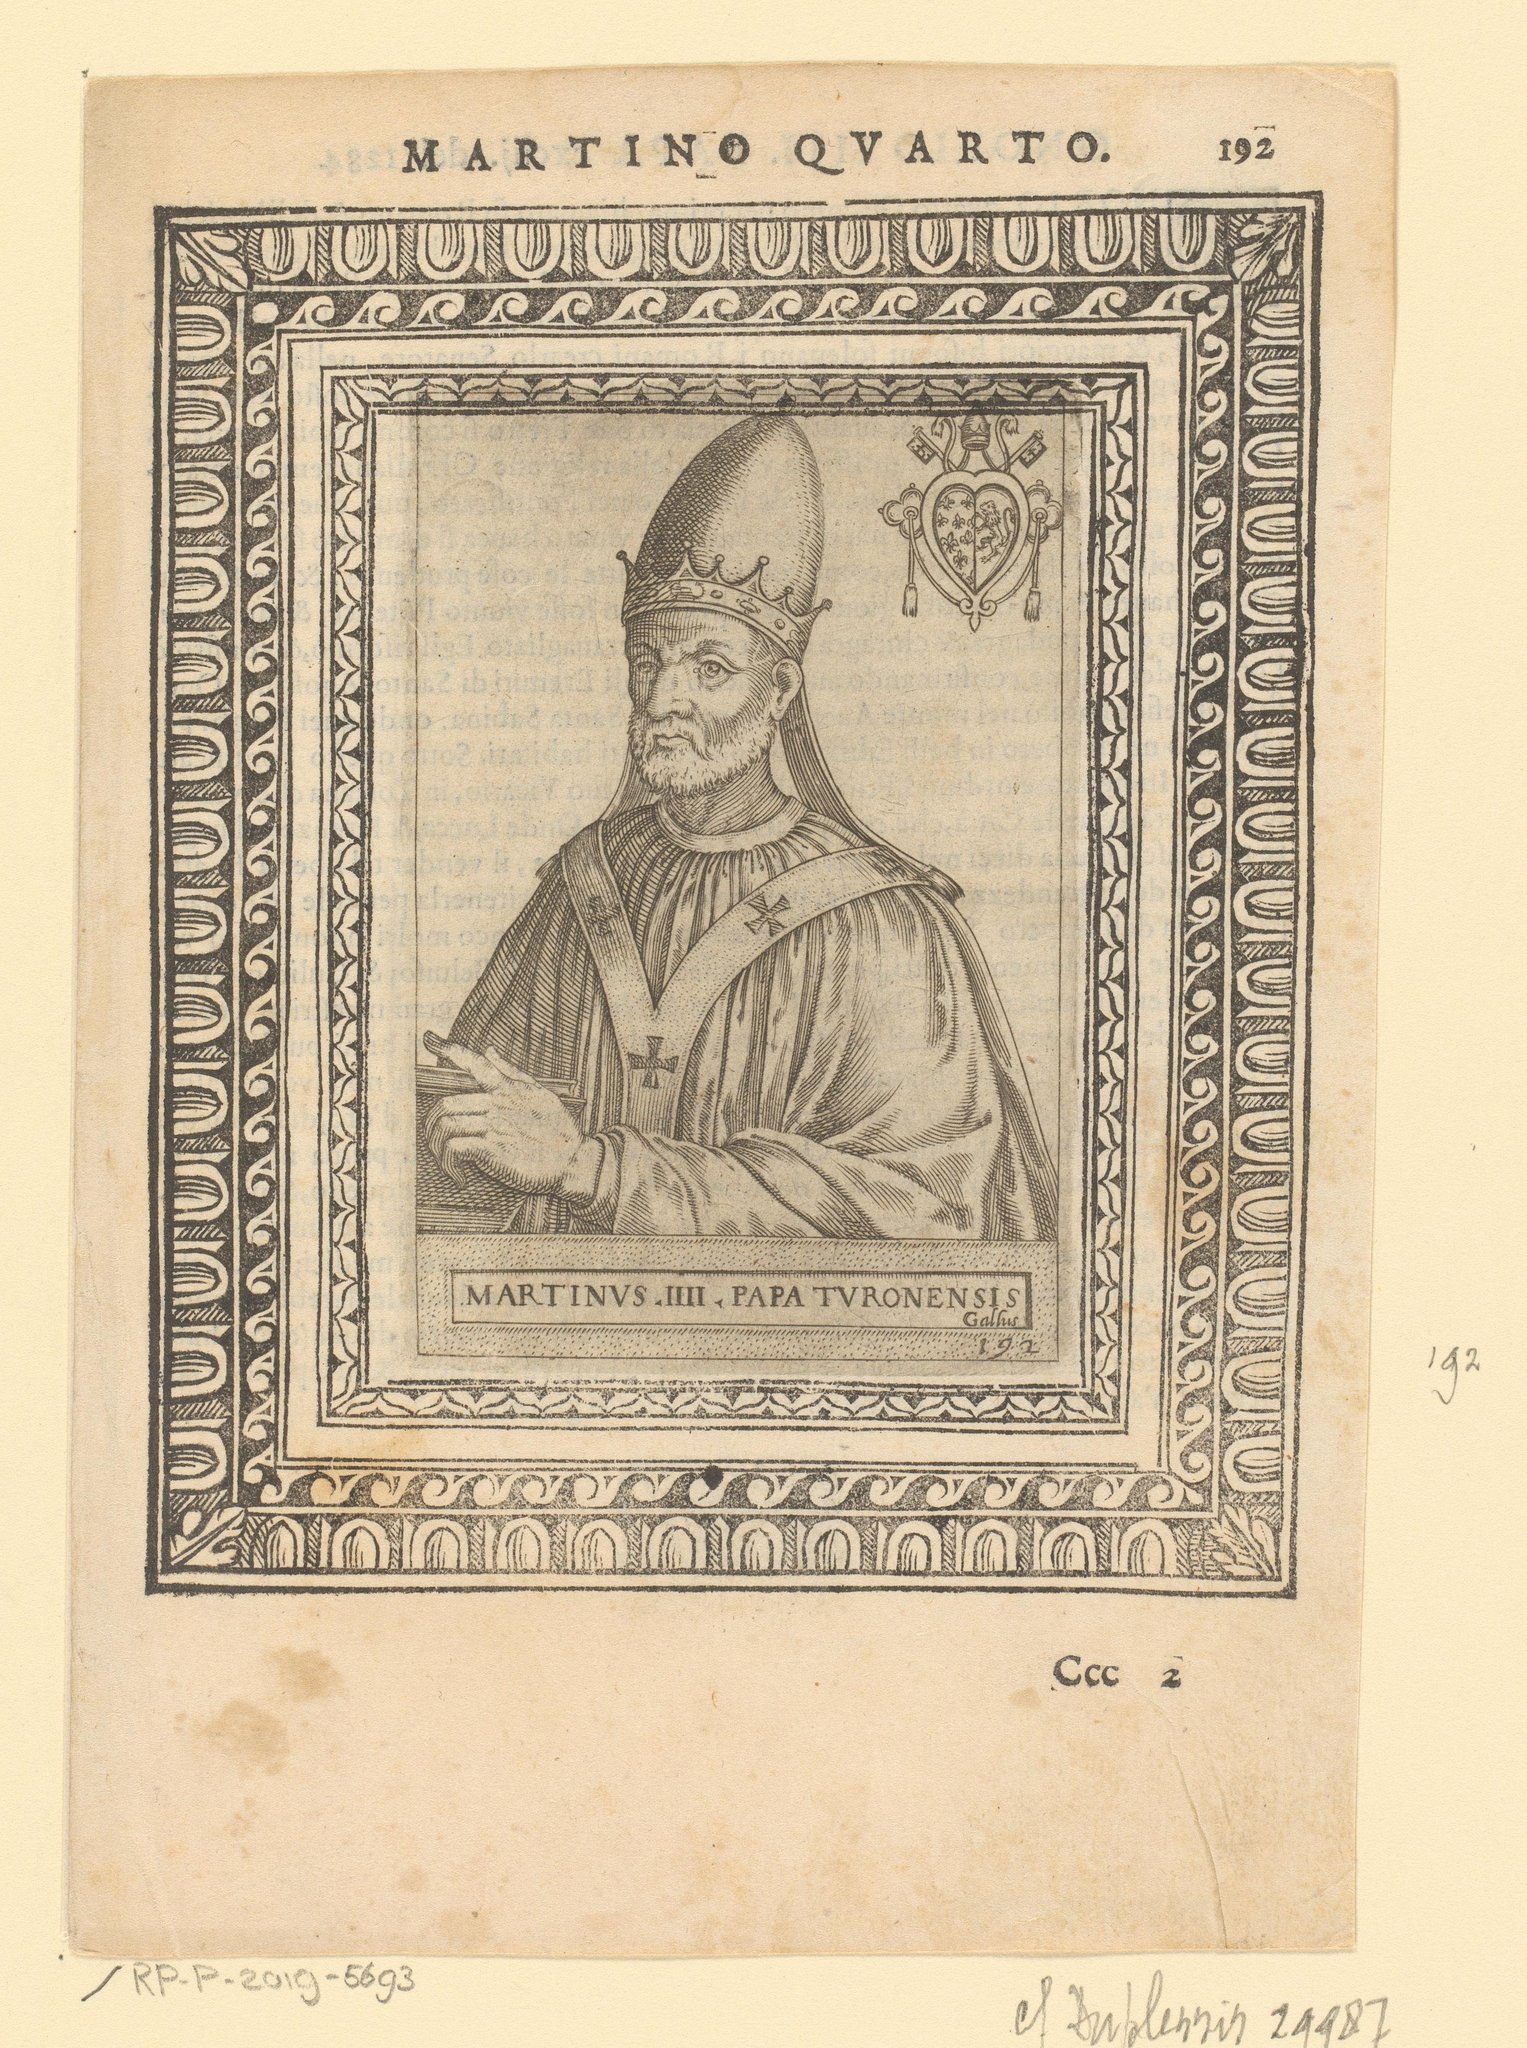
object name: print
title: Martinus IIII Papa Turonensis Gallus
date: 1587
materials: paper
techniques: engraving, letterpress printing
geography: rome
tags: historical persons, pope, armorial bearing, heraldry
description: Prent uit: Ciccarelli, Antonio. Le vite de Pontefici di Antonio Ciccarelli (...). Rome: Domenico Basa, 1587. Prent voor het eerst verschenen in: Cavalieri, Giovanni Battista de'. Pontificum romanorum effigies (...). Rome: Domenico Basa en Francesco Zanetti, 1580. Prent ook gebruikt in latere publicaties.